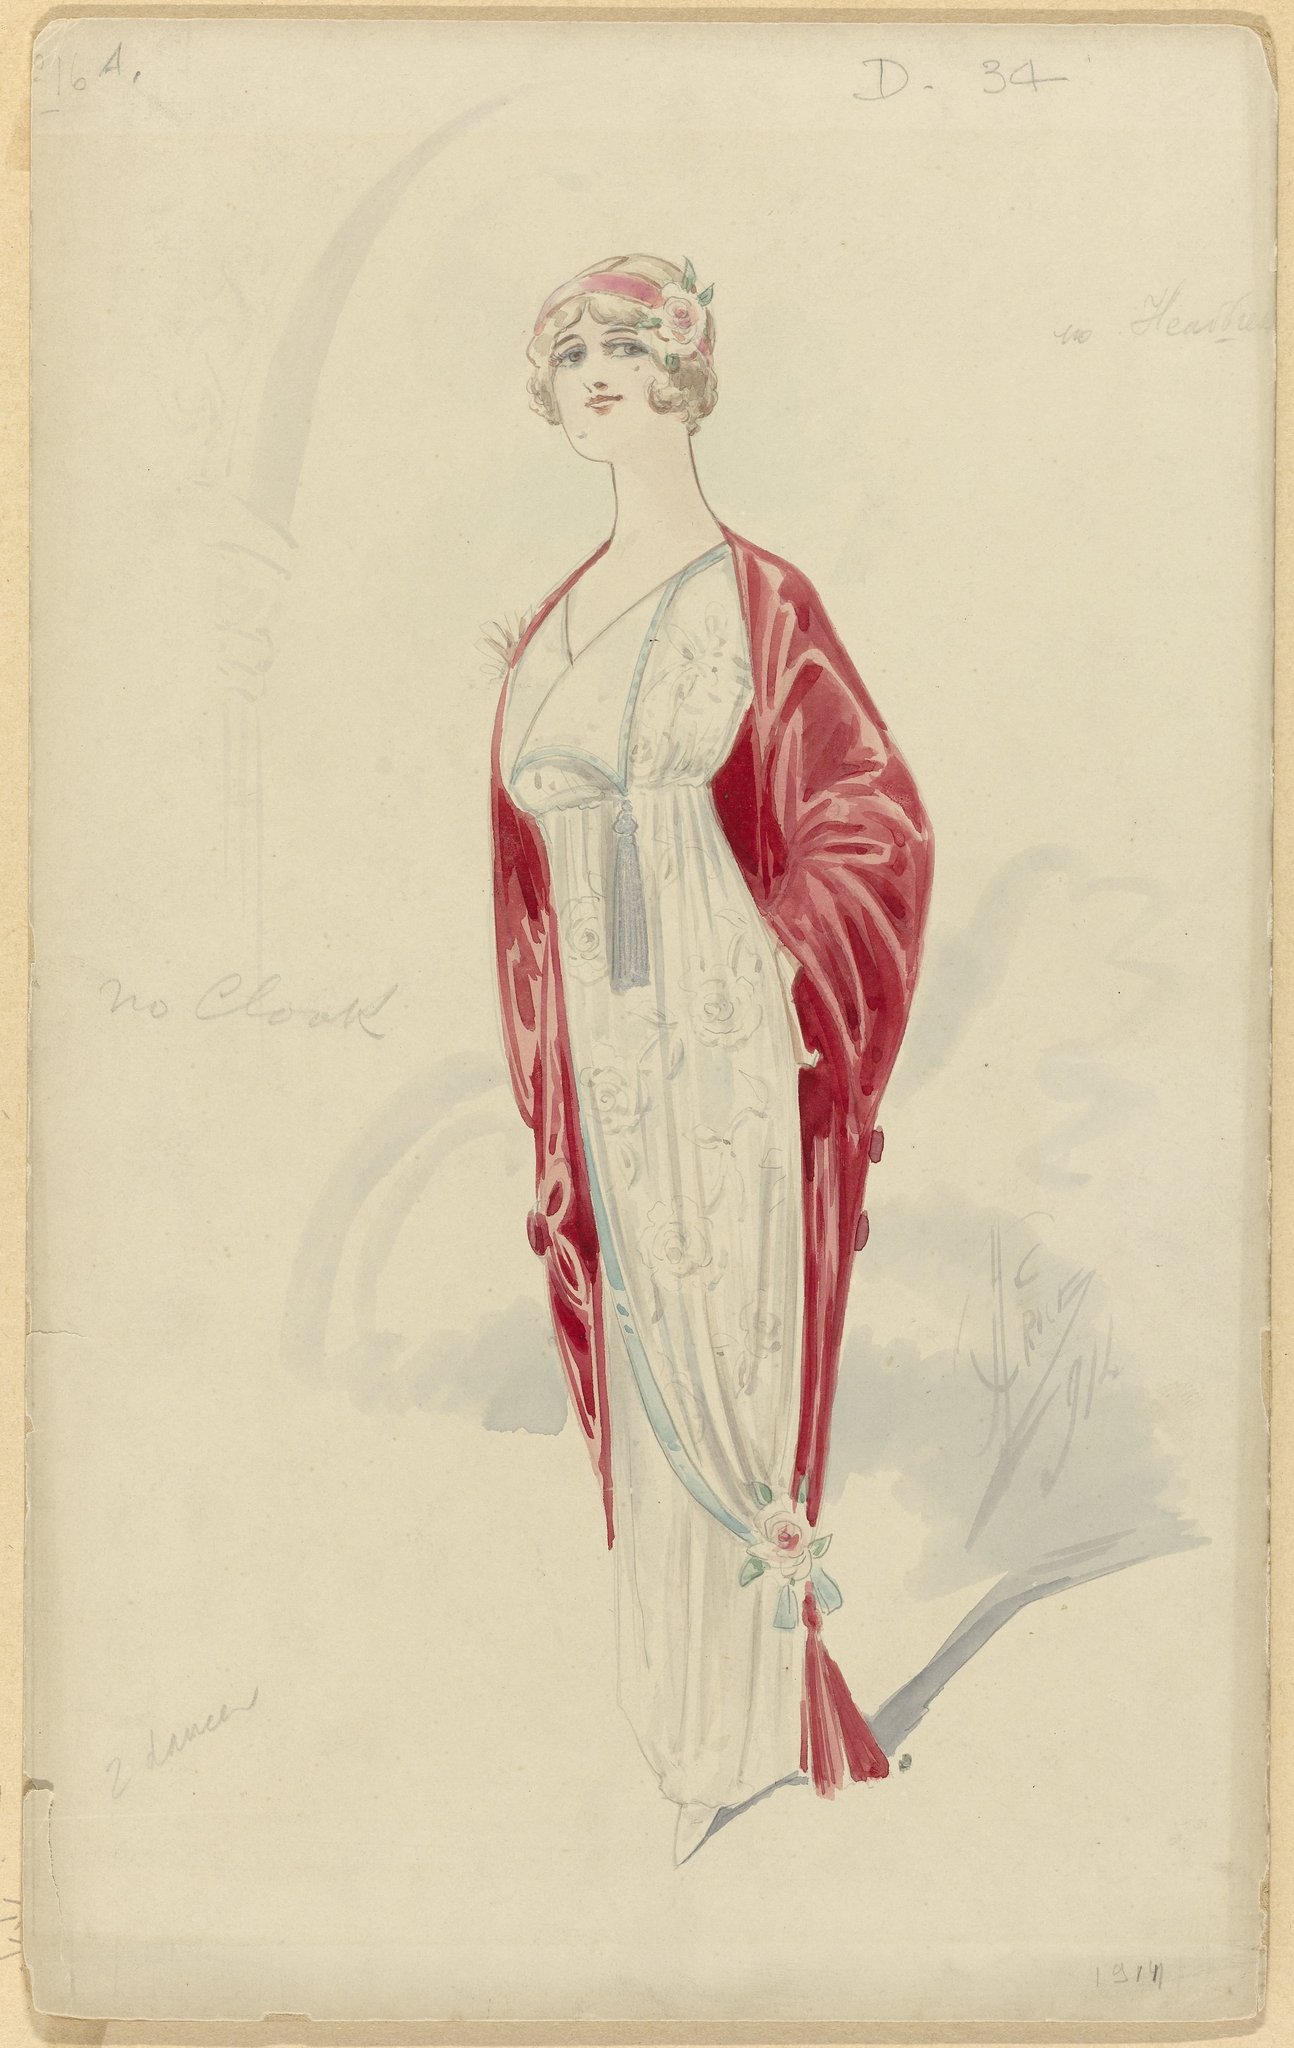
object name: watercolor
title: Vrouw in witte avondjurk met bloempatroon, 1914, No. D.34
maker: price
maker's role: artist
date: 1914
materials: paper, pencil, watercolor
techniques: brush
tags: dress, gown: evening dress (+ women's clothes), fashion plates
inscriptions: date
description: Strakke, tot op de enkels vallende avondjapon in witte stof met bloemmotief. Aan een van de revers van de kraag hangt een kwast. Een lint hangt van het middel schuin naar onderen, uitmondend in een roos. Over de japon een rode avondcape. Rode haarband met bloem.